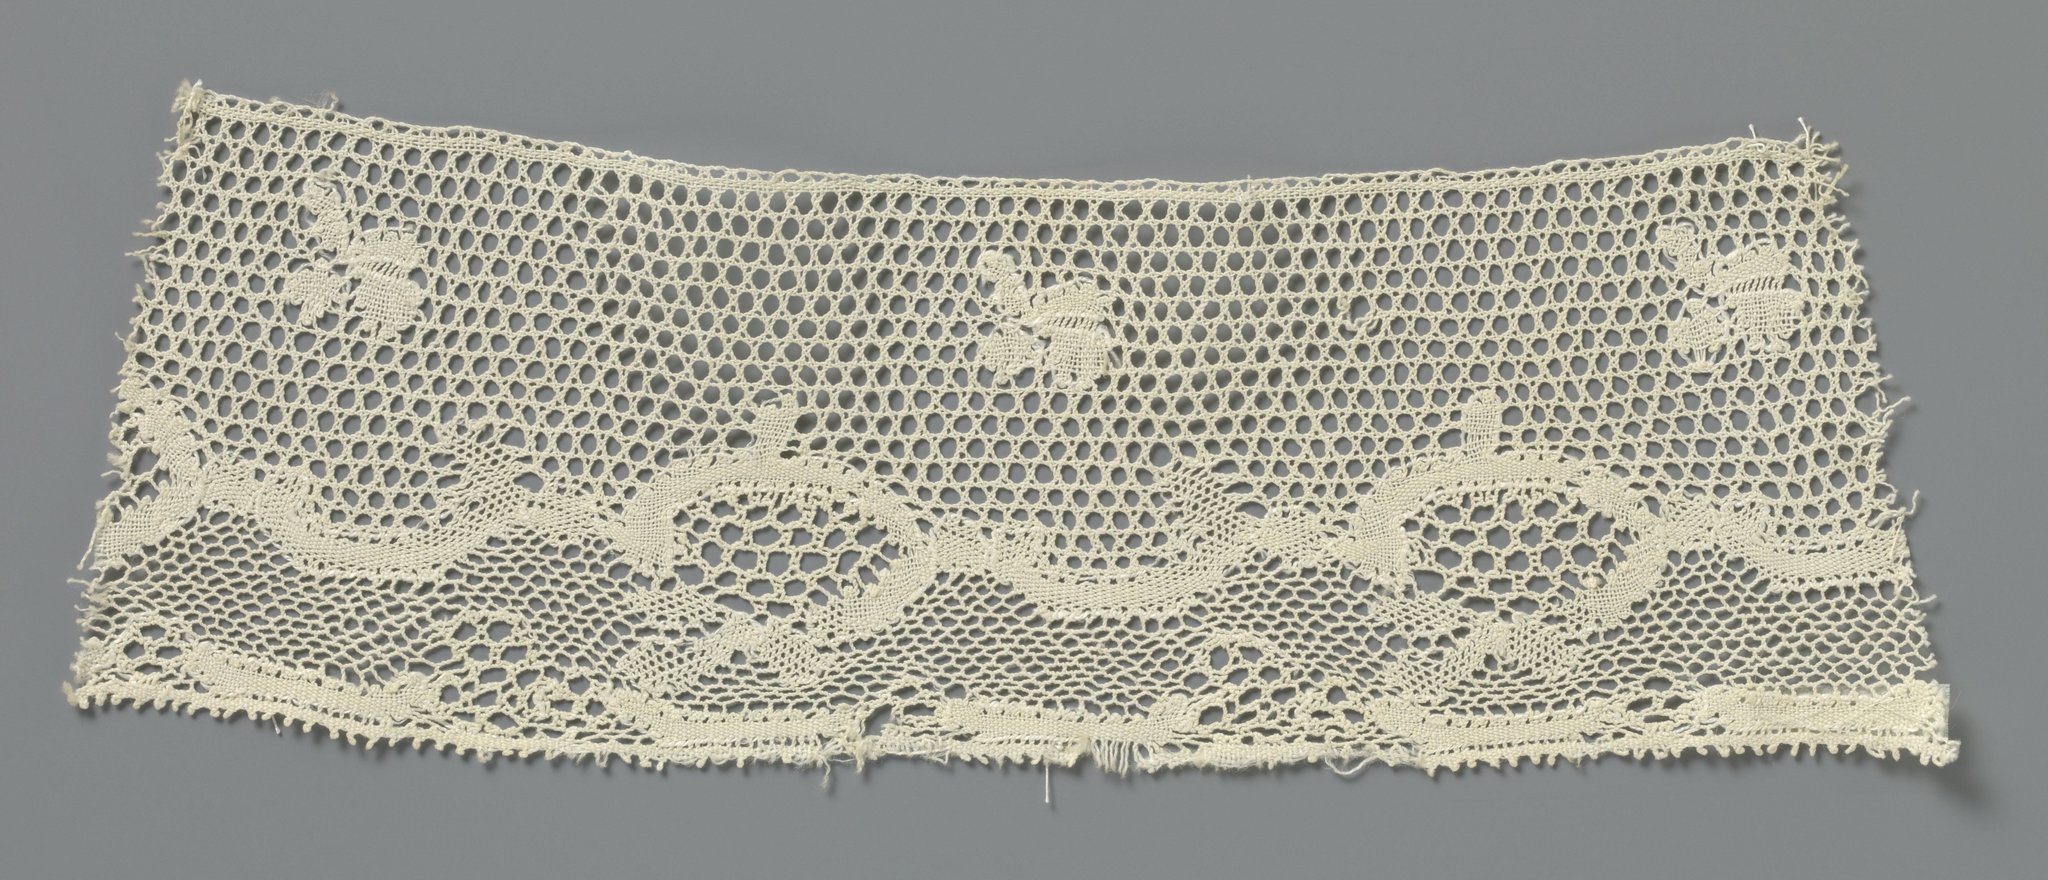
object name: strip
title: Strook kloskant met aaneengeschakelde c-vormige motieven en strikken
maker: Anonymous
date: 1900-1924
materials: linen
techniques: lace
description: Strook naturelkleurige kloskant. Boven de middenlijn van de strook staat een rij vlinders of blaadjes. Het patroon daaronder bestaat uit een aaneenschakeling van liggende c-vormig motieven, die afwisselend met de open zijde omhoog en naar beneden gericht zijn. Onder de c-vormige motieven met de opening naar beneden hangt een soort strik, waardoor een ovale ruimte ontstaat. De motieven zijn met elkaar verbonden door een twee verschillende maasgronden: boven de c's met een Parijse grond en daaronder door een ronde Valenciennes-grond. De motieven zijn gemaakt in linnenslag en netslag, deels voorzien van dikkere en glimmende contourdraden. Als siergrond is een rozengrond toegepast. De boven- en onderzijde van de strook zijn recht afgewerkt, waarbij de onderzijde is voorzien van picots.